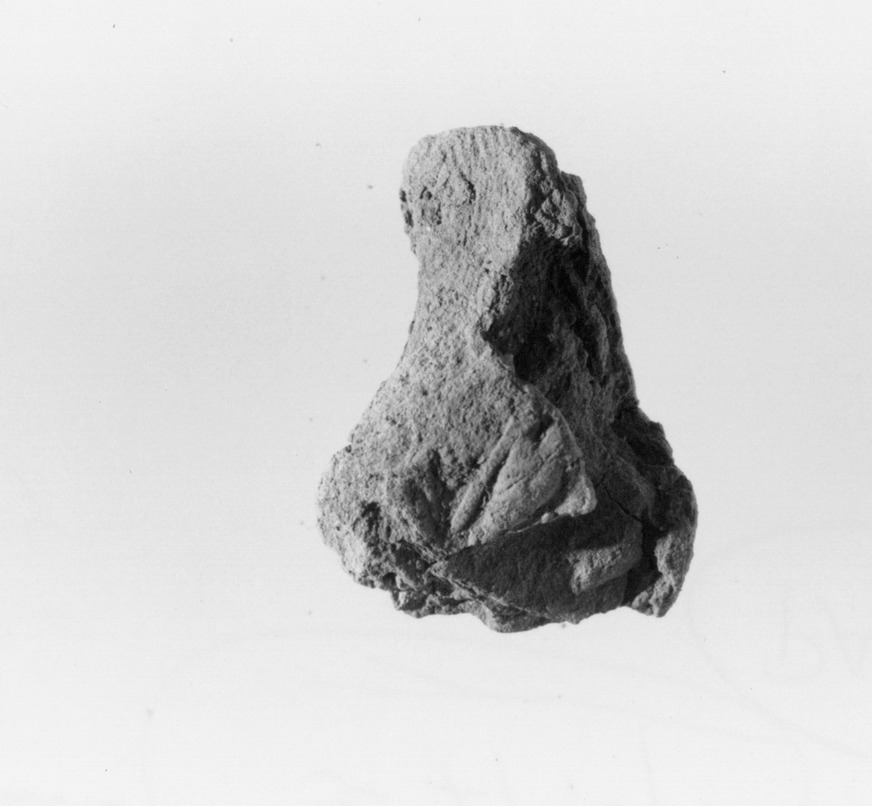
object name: sealing, nebmaatre, amenhotep iii, thoth, double crown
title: Document Sealing With the Throne Name of Amenhotep III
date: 1390-1352 BCE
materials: mud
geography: egypt